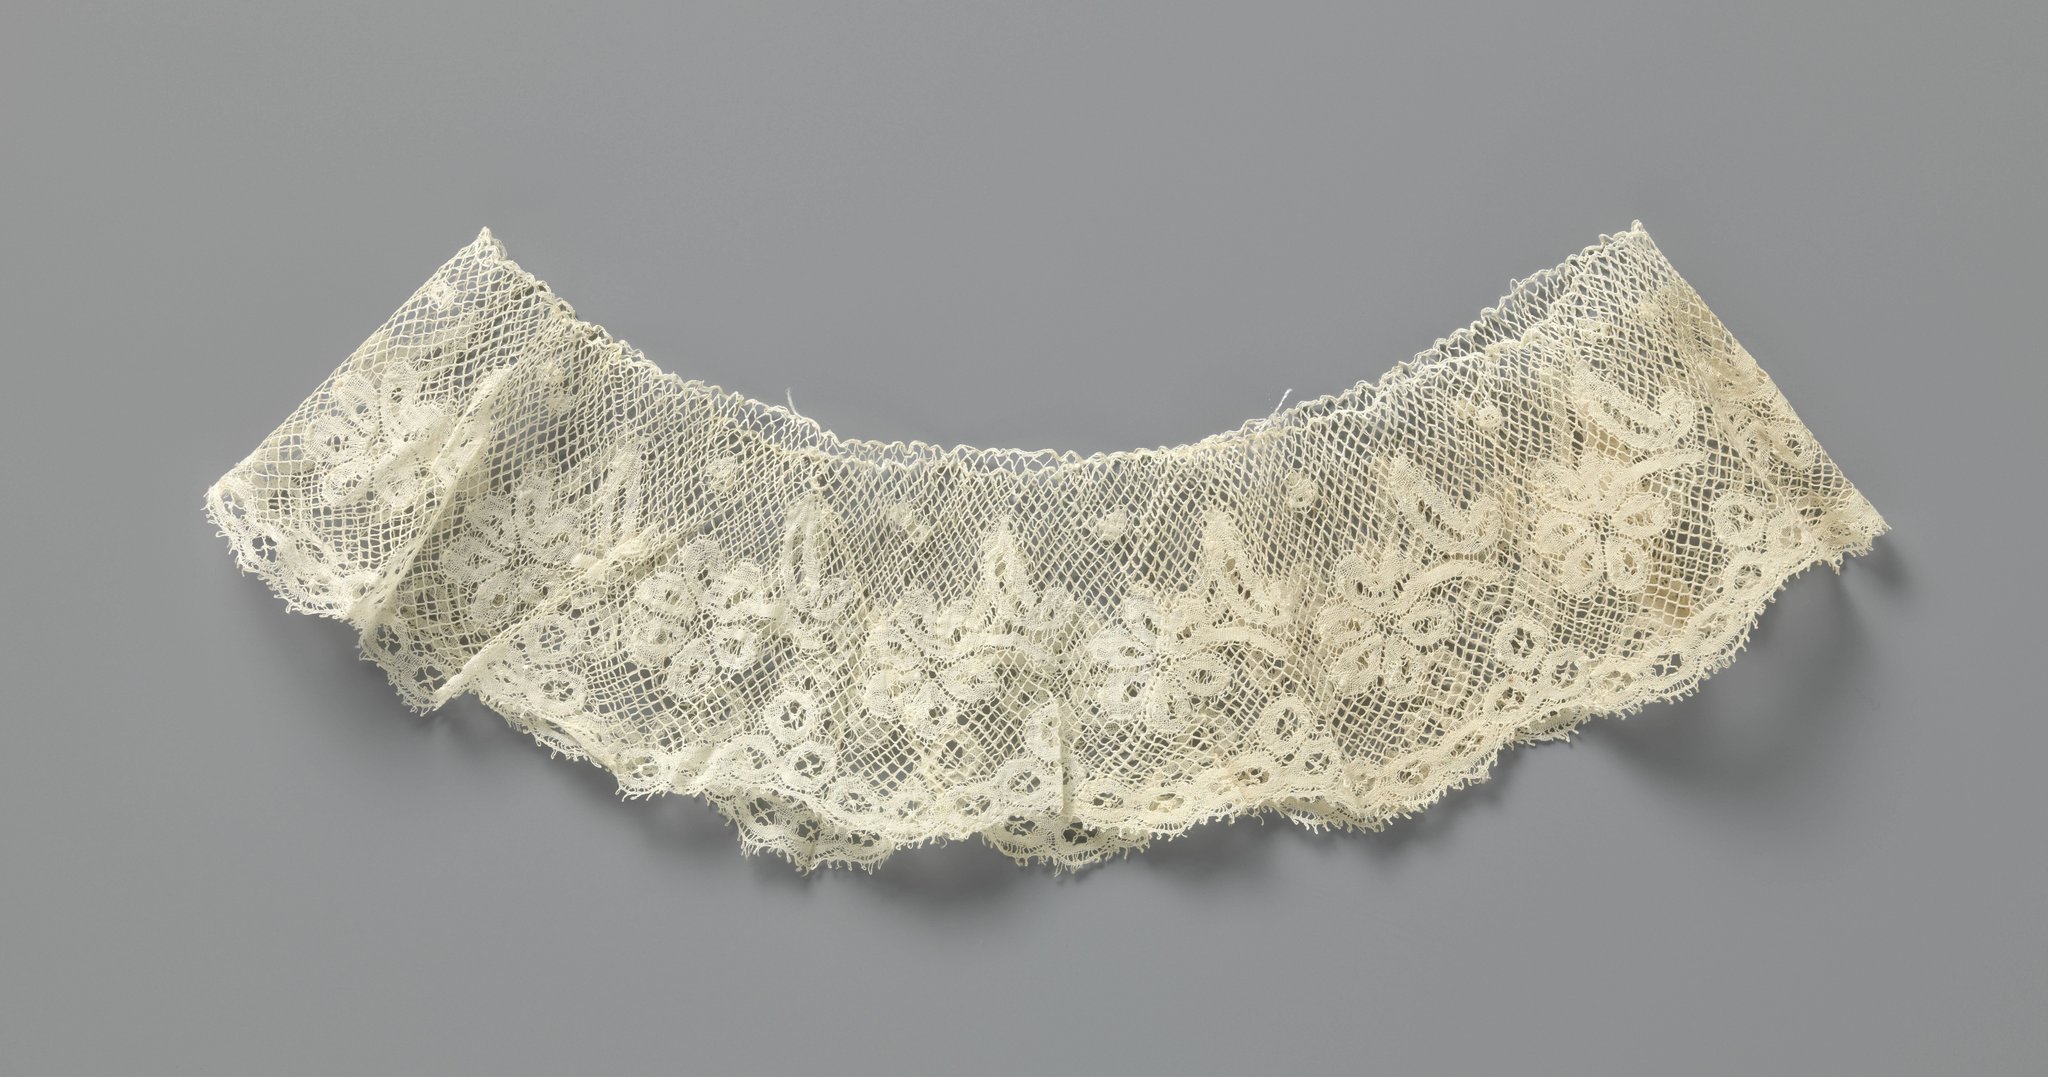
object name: cuff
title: Manchet van kloskant met margrietjes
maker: Anonymous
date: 1900-1924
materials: linen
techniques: lace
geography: sluis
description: De strook met margrietjes bestond volgens de catalogus 'Kant uit Koninklijk bezit' uit drie losse delen en had één inventarisnummer: J-272. Mogelijk voor een tentoonstelling zijn hier echter meerdere delen van gemaakt of zijn er juist delen aan elkaar genaaid of vermaakt tot een kraag en manchetten. Aan de verschillende delen zijn subnummers toegekend. De totale lengte van deze stroken bij elkaar is om onduidelijke redenen langer dan de in de catalogus aangegeven totaallengte van J-272.